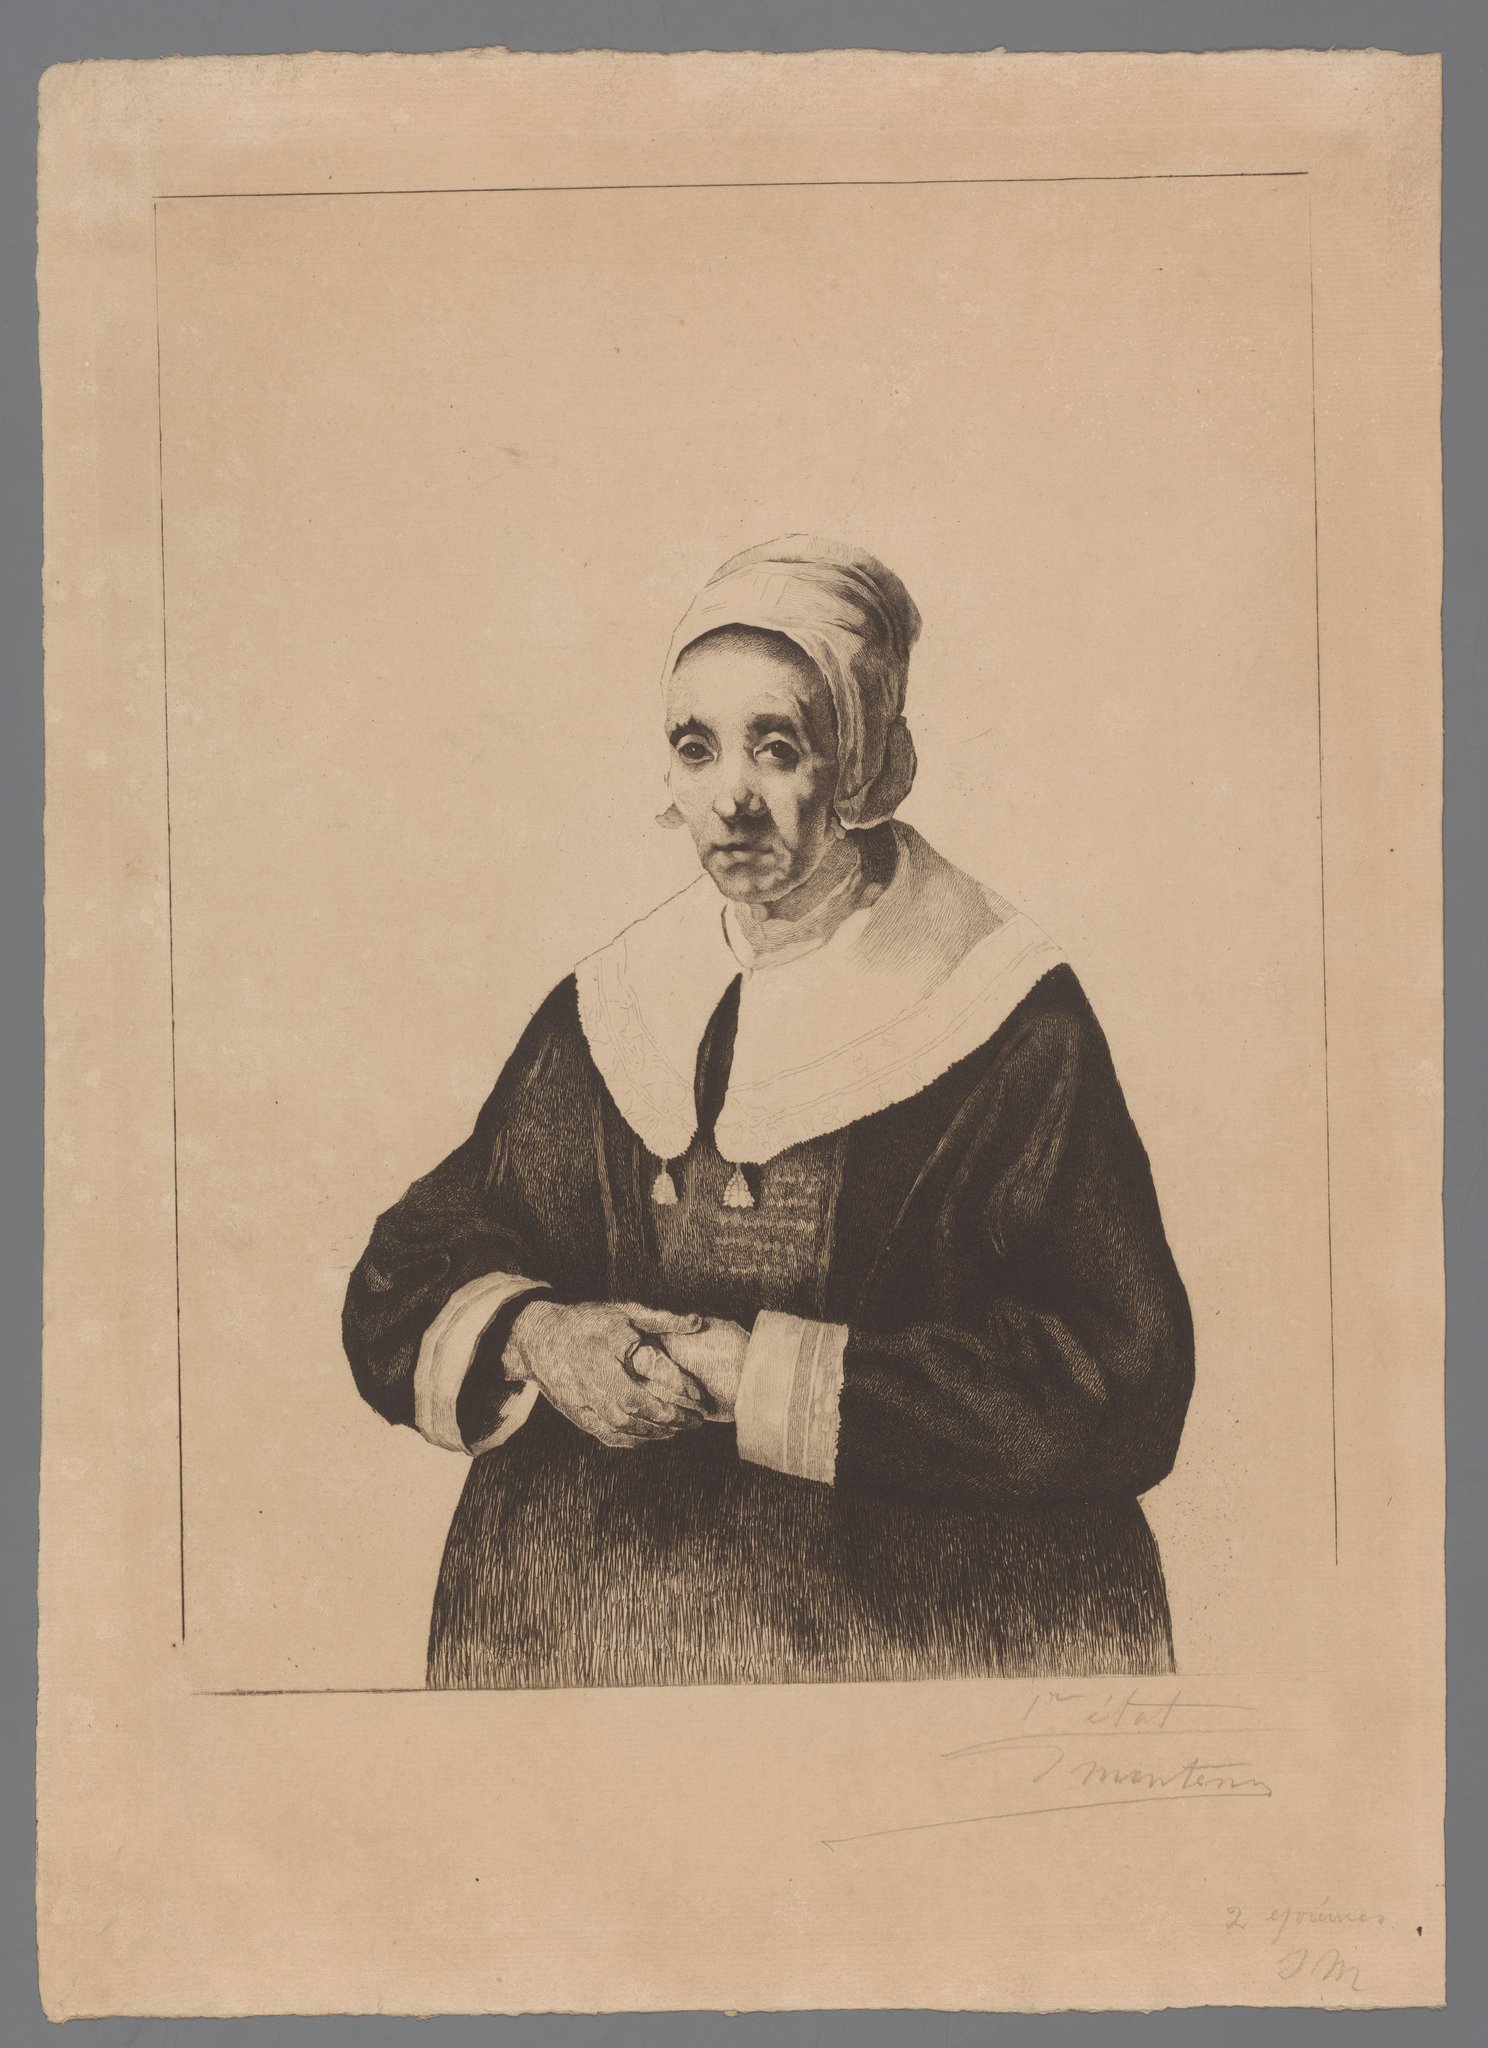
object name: print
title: Portret van een onbekende vrouw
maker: georges montenez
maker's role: print maker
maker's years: 1873-1930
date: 1883-1913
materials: paper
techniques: etching, intaglio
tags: adult woman, historical persons, head-gear: cap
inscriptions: collector's mark: Lugt 2228, inscription: ‘2 epréuves’